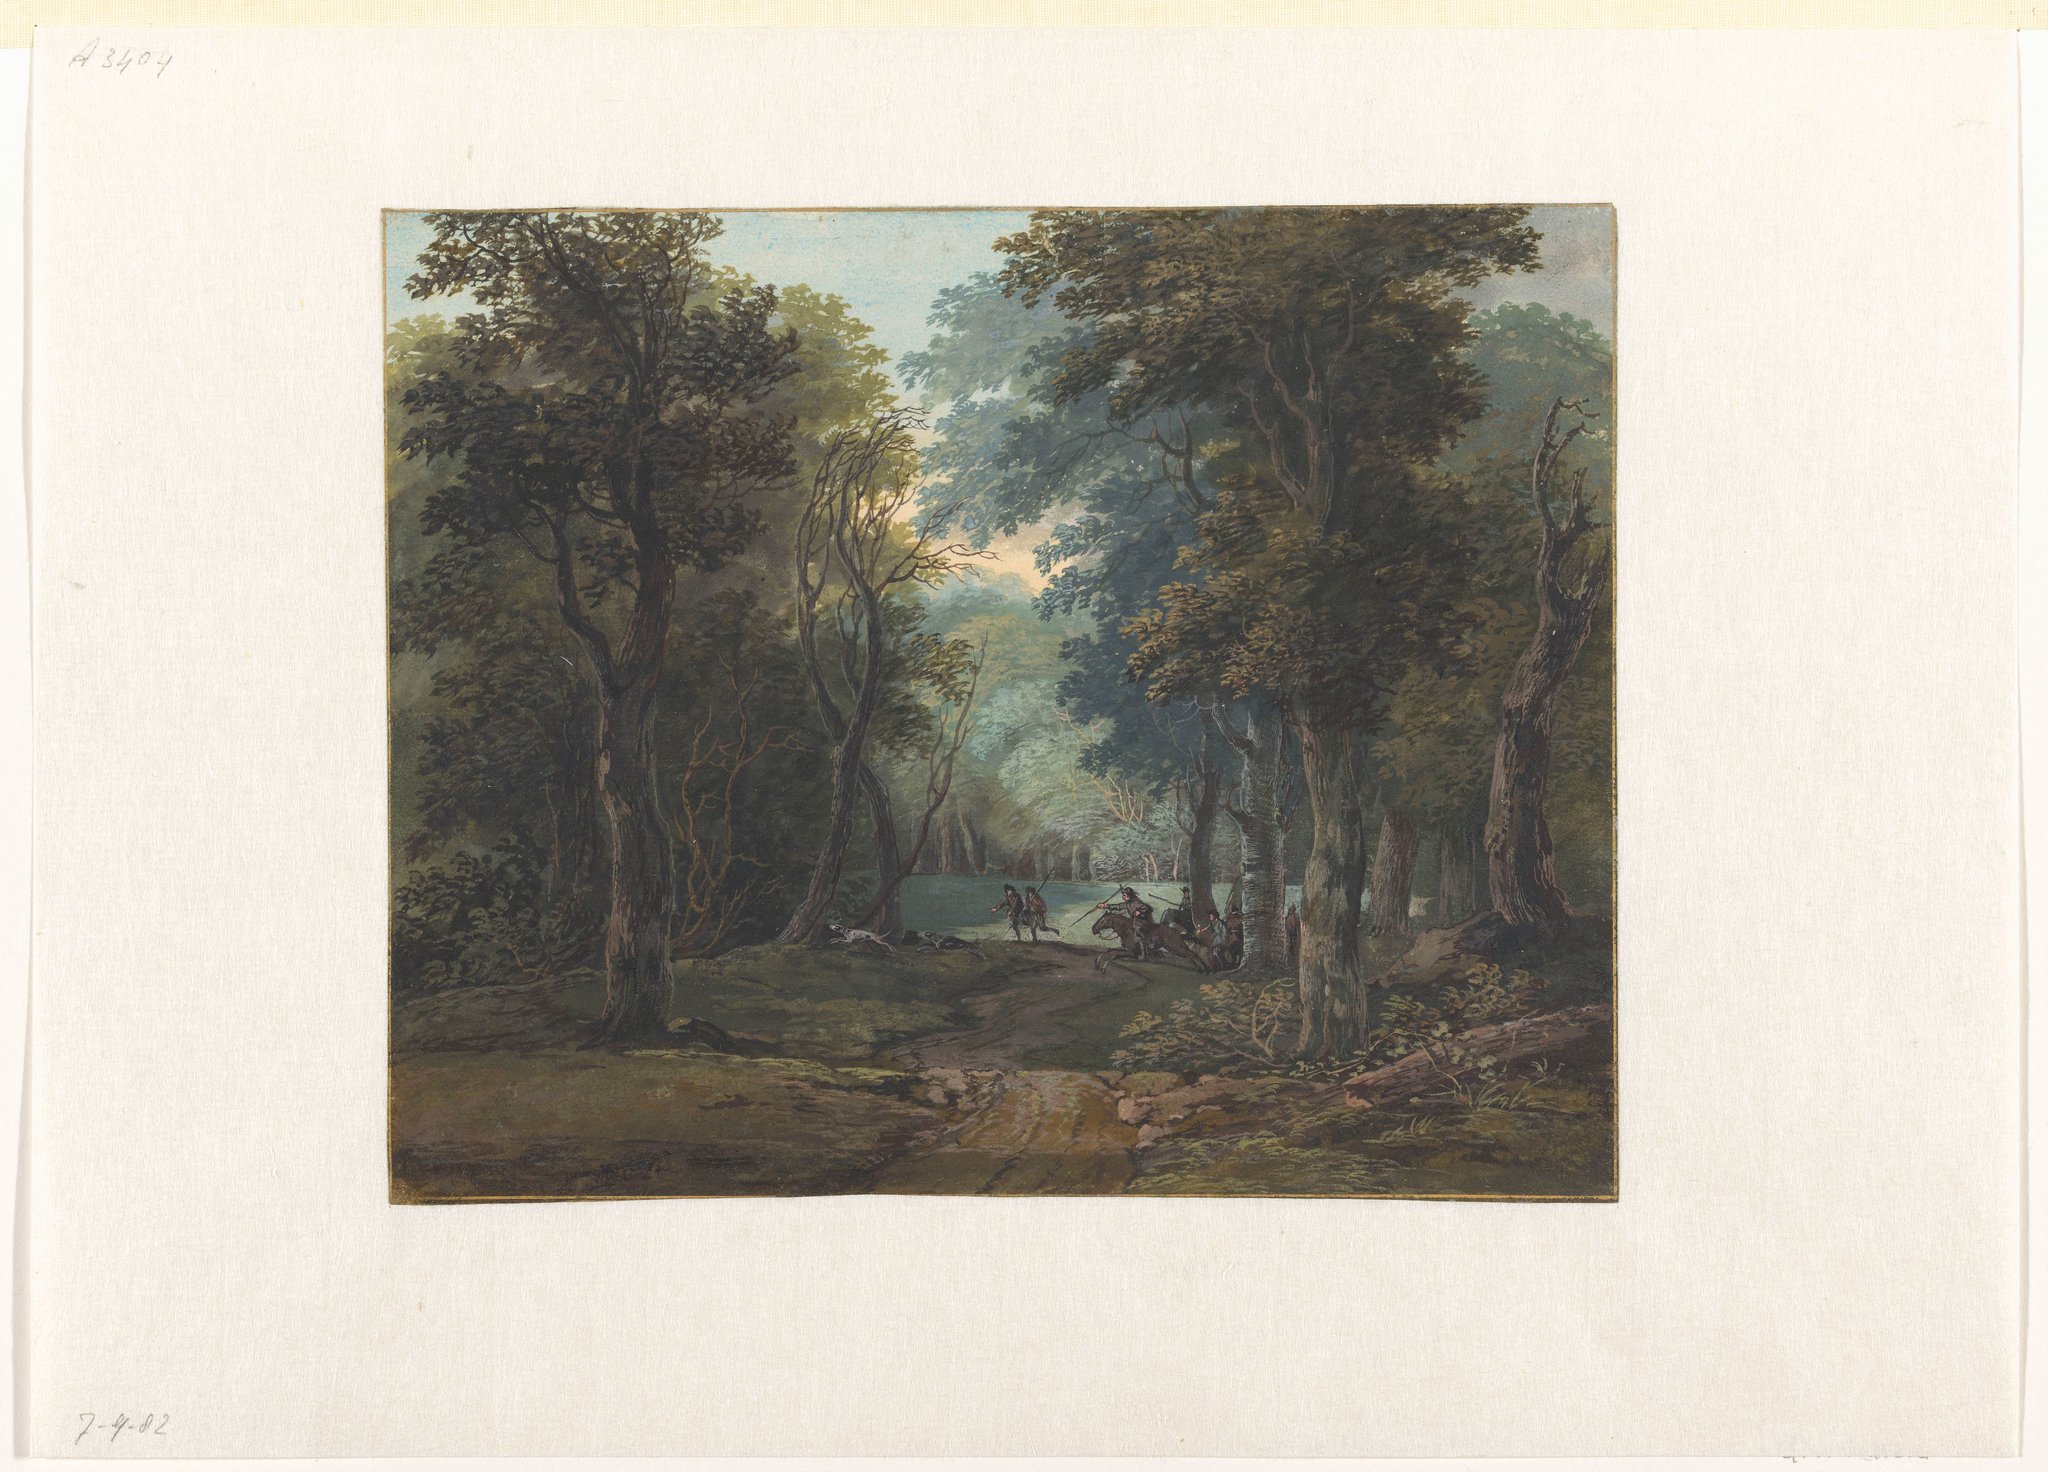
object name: drawing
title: Jagers in een bos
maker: gerrit battem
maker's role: draughtsman, painter, print maker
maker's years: 1636-1684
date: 1646-1684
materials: paint, gouache, paper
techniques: brush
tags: hunting, chase, forest, wood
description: Op een open plaats in een bos beweegt zich een jachtstoet, bestaand uit jagers te voet en te paard en honden, van rechts naar links.